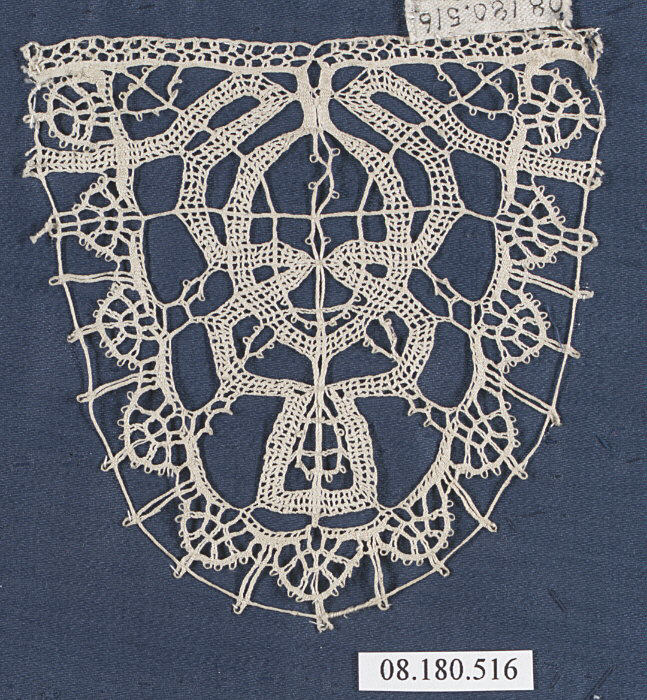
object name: fragment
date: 1801-1900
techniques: lace